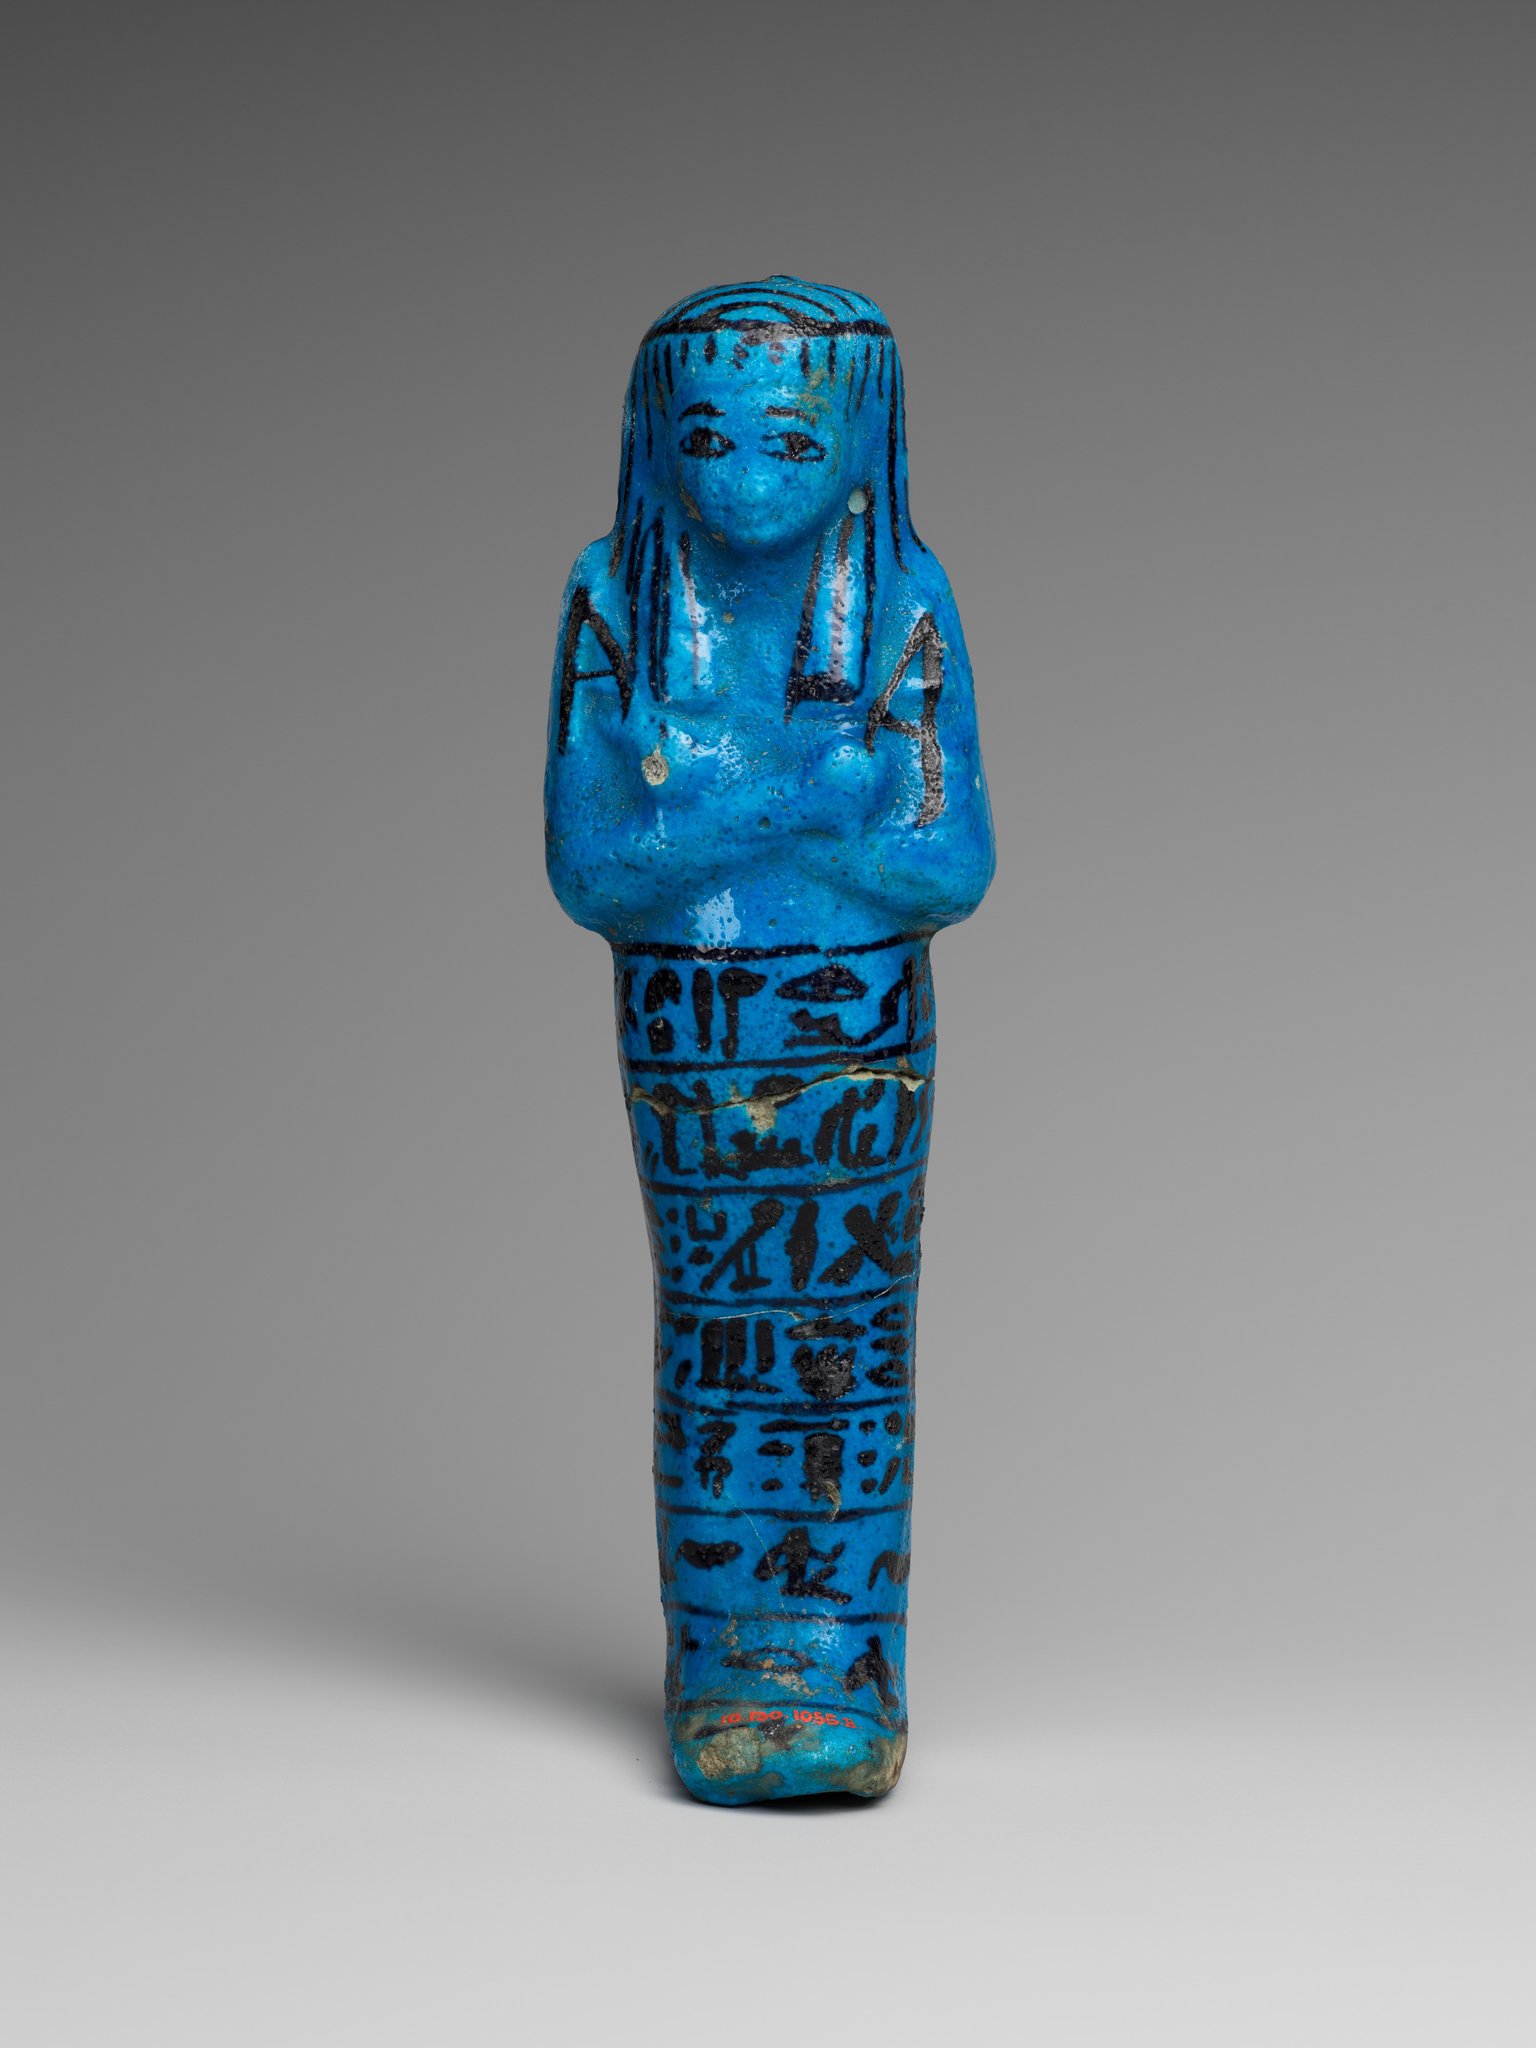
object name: shabti, painedjem ii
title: Shabti of the High Priest of Amun, Painedjem II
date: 988-966 BCE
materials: faience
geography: upper egypt, thebes